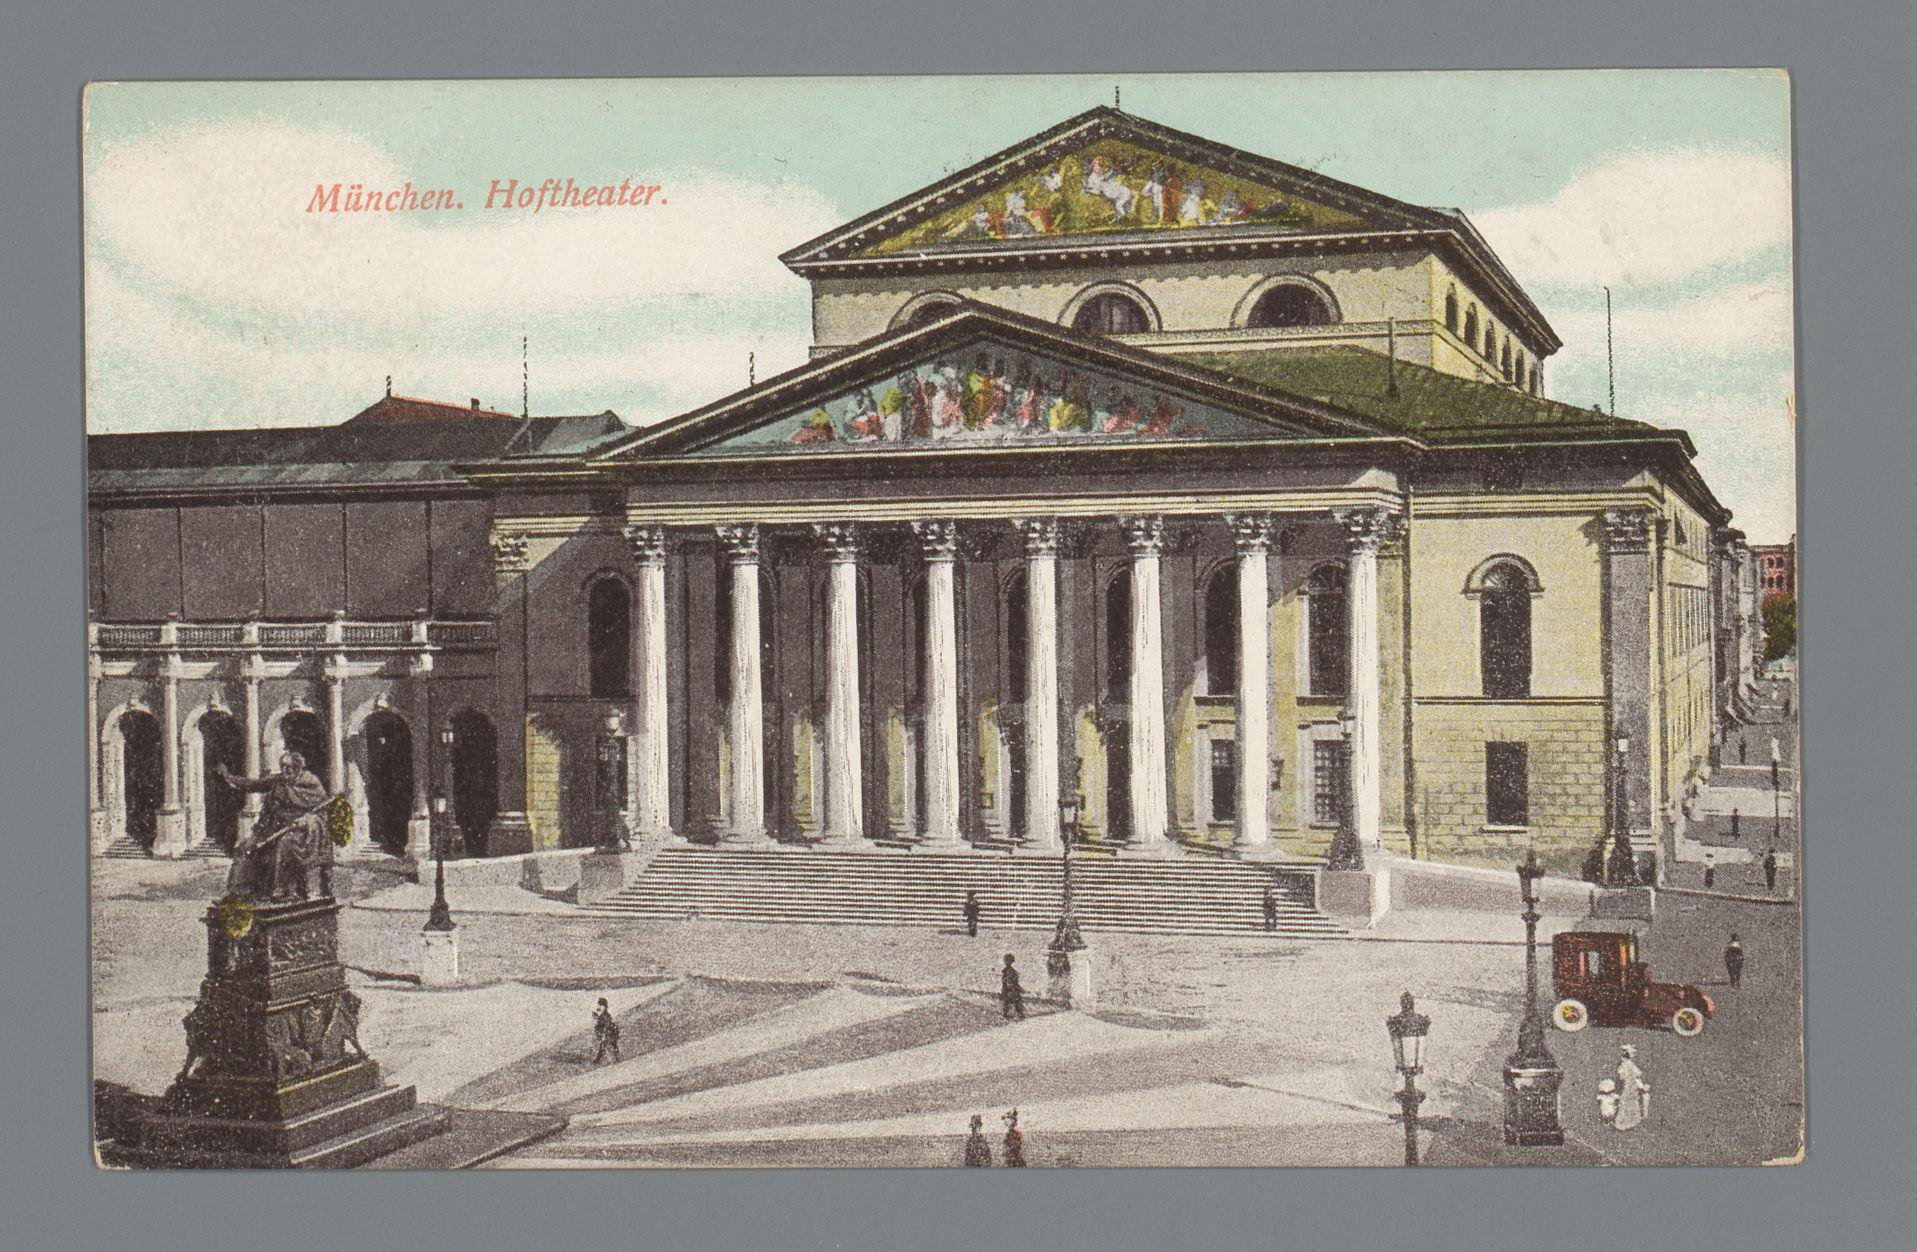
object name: photomechanical print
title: München, Hoftheater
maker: Anonymous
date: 1910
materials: paper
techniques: lithograph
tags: theatre (building)